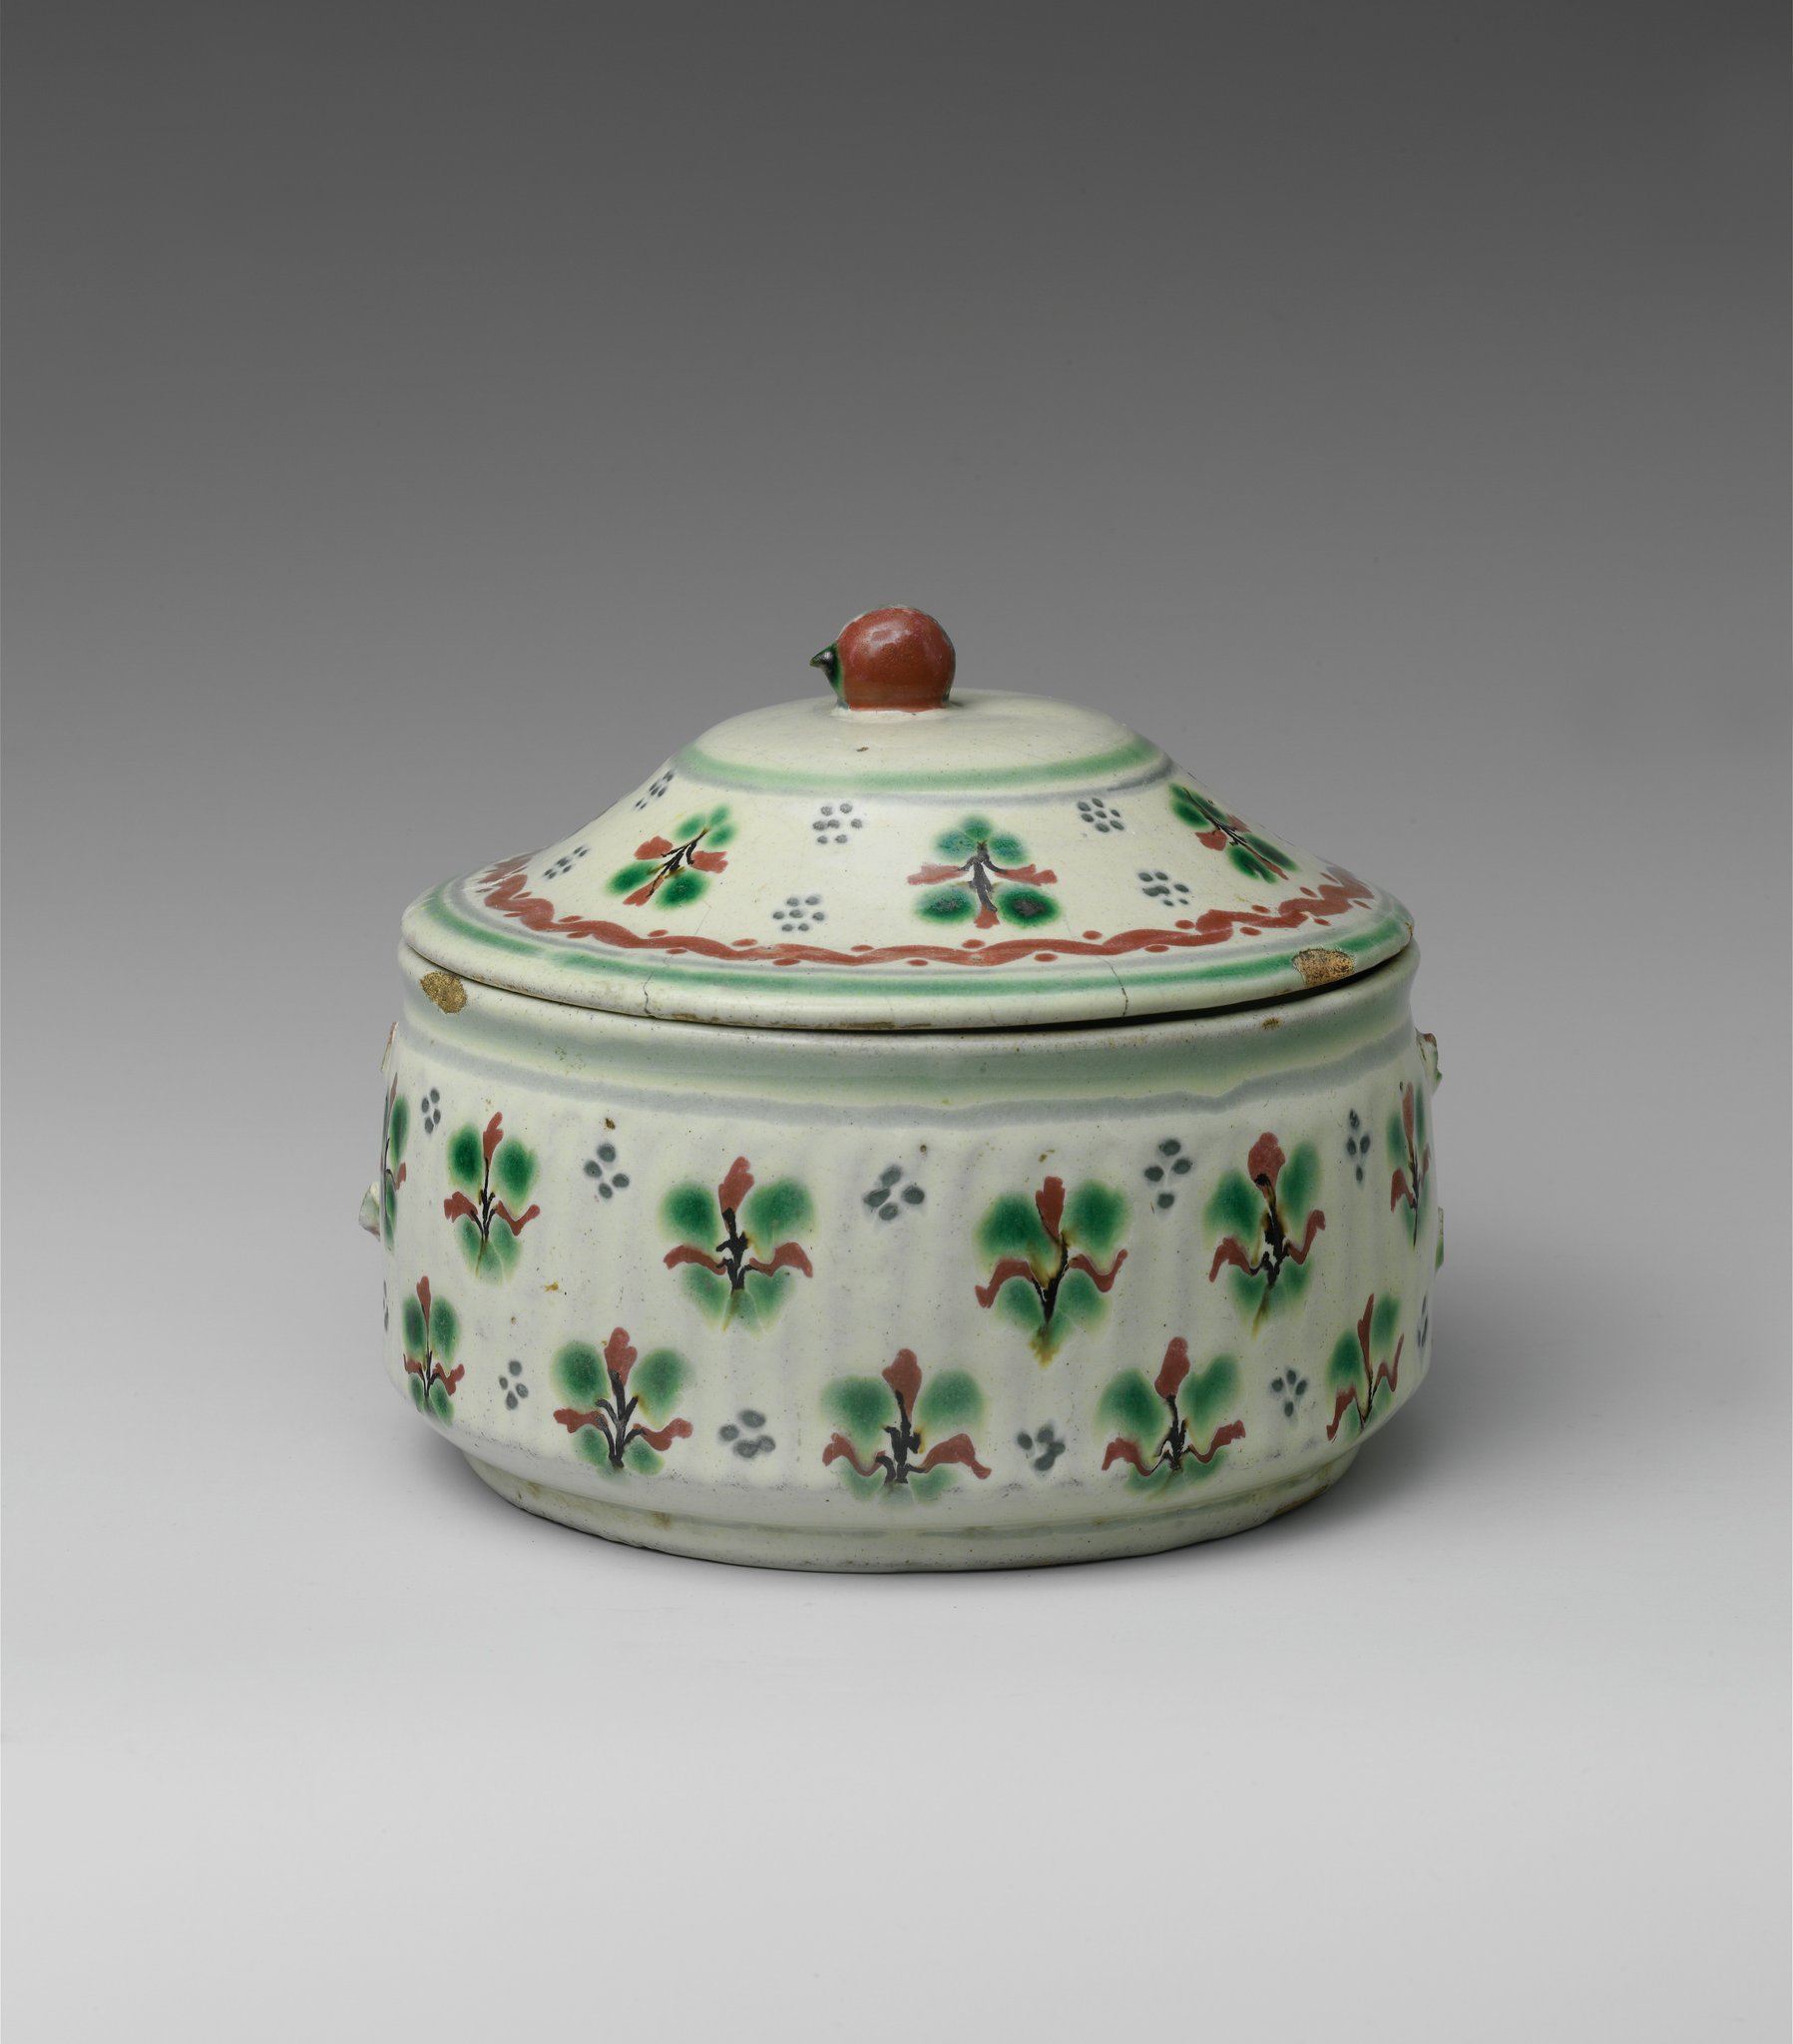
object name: bowl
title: Covered Bowl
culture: mexican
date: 1825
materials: earthenware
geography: mexico